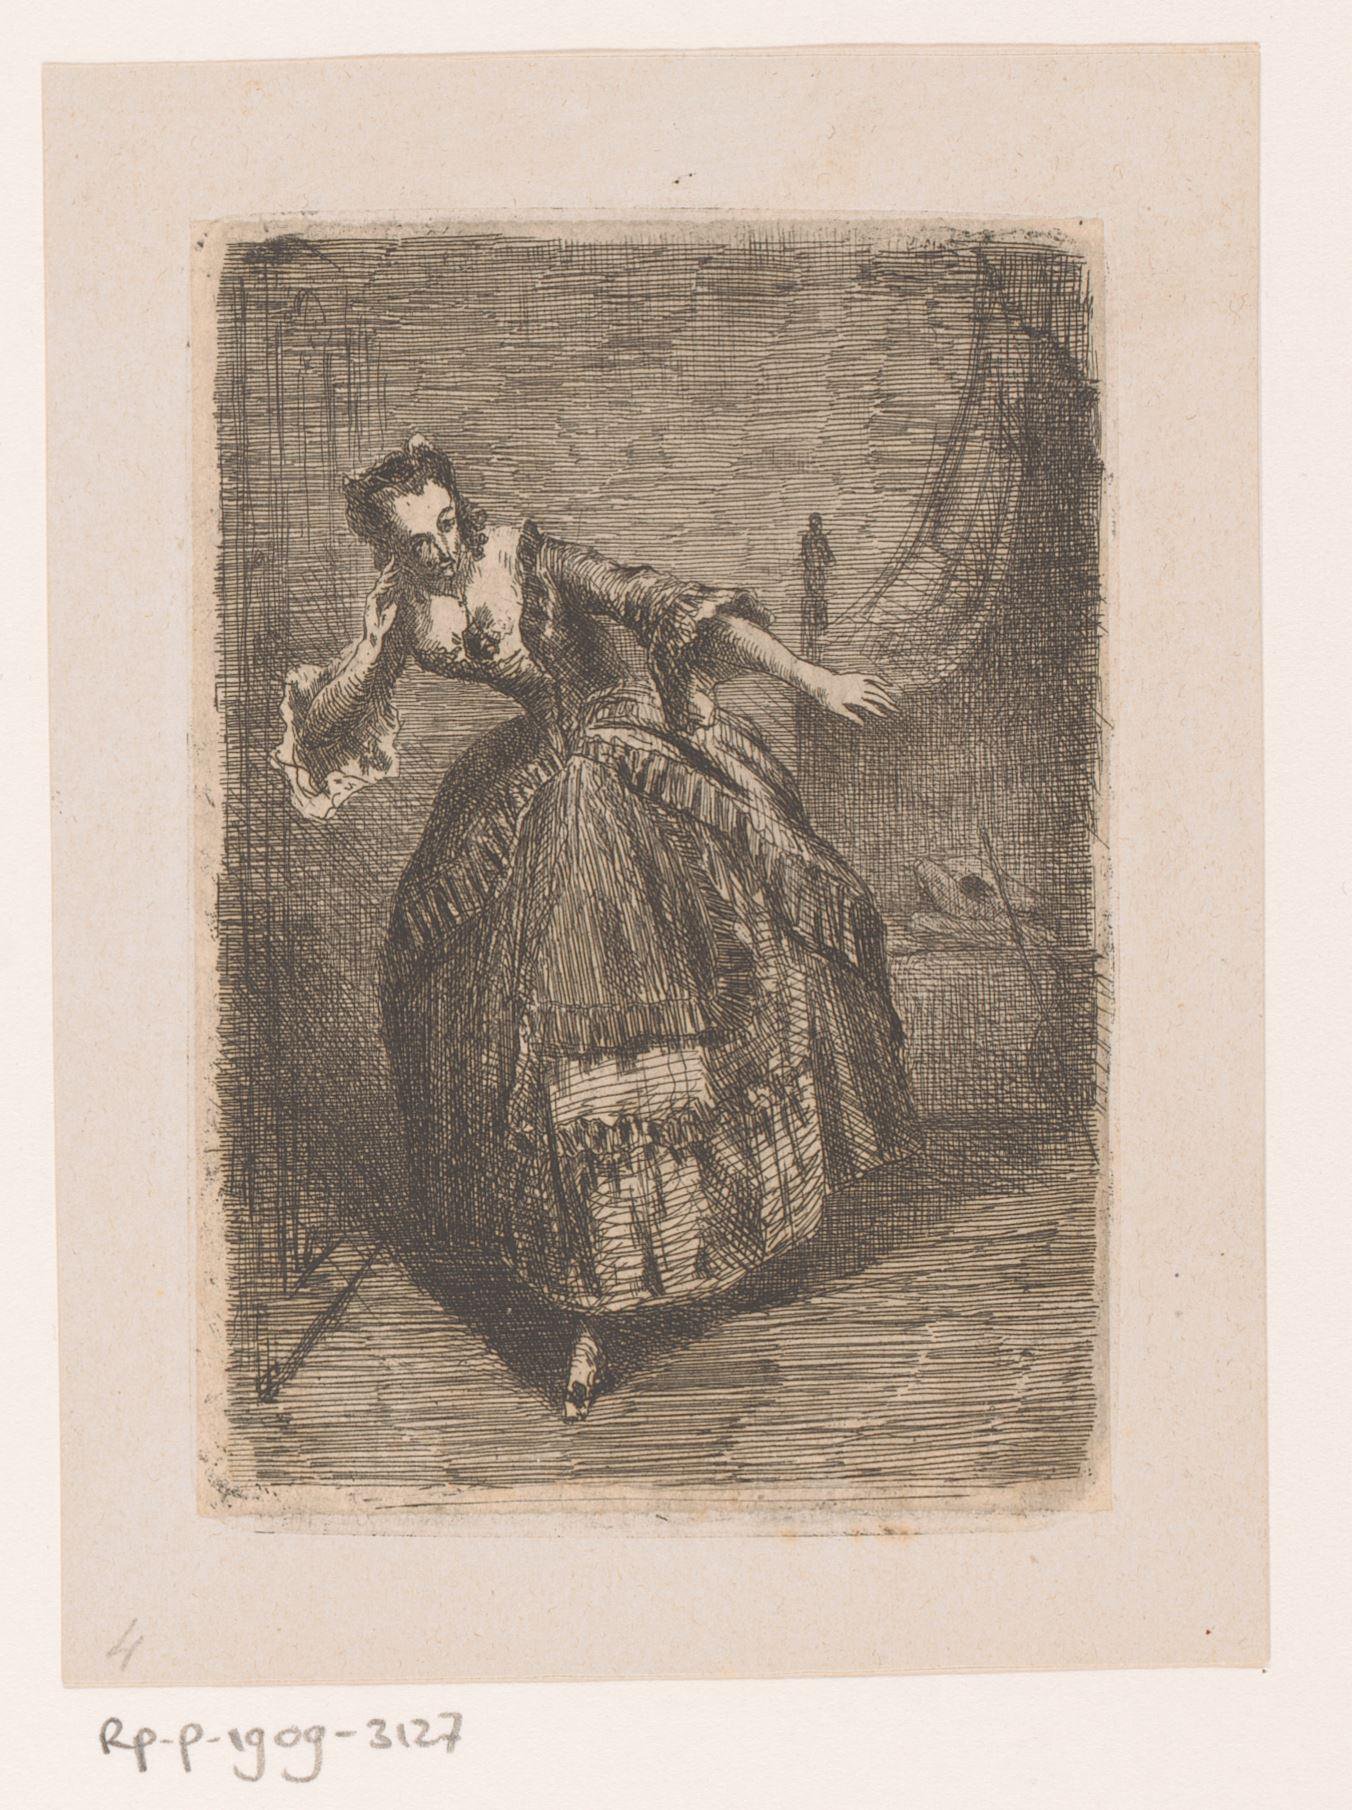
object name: print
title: Luisterende jonge vrouw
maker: florent nicolas crabeels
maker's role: print maker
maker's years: 1829-1896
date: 1839-1879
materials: paper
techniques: etching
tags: eavesdropper - aa - female human figure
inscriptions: collector's mark: Lugt 1485, collector's mark: Lugt 2228